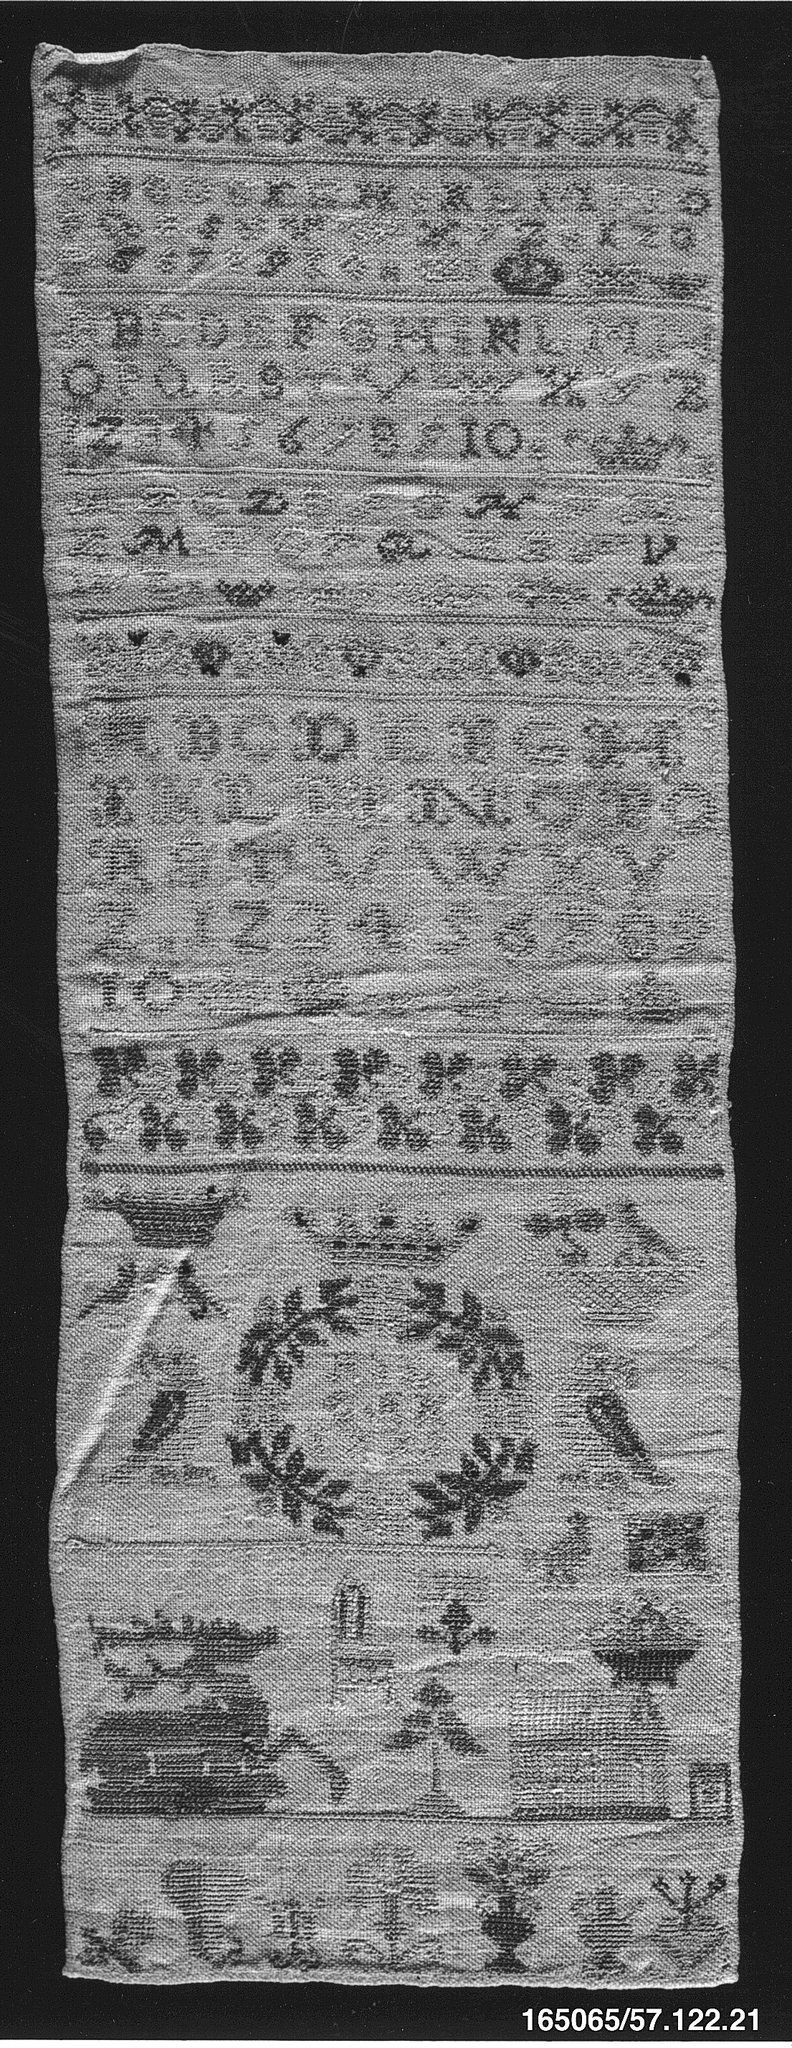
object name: sampler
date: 1779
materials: linen, silk